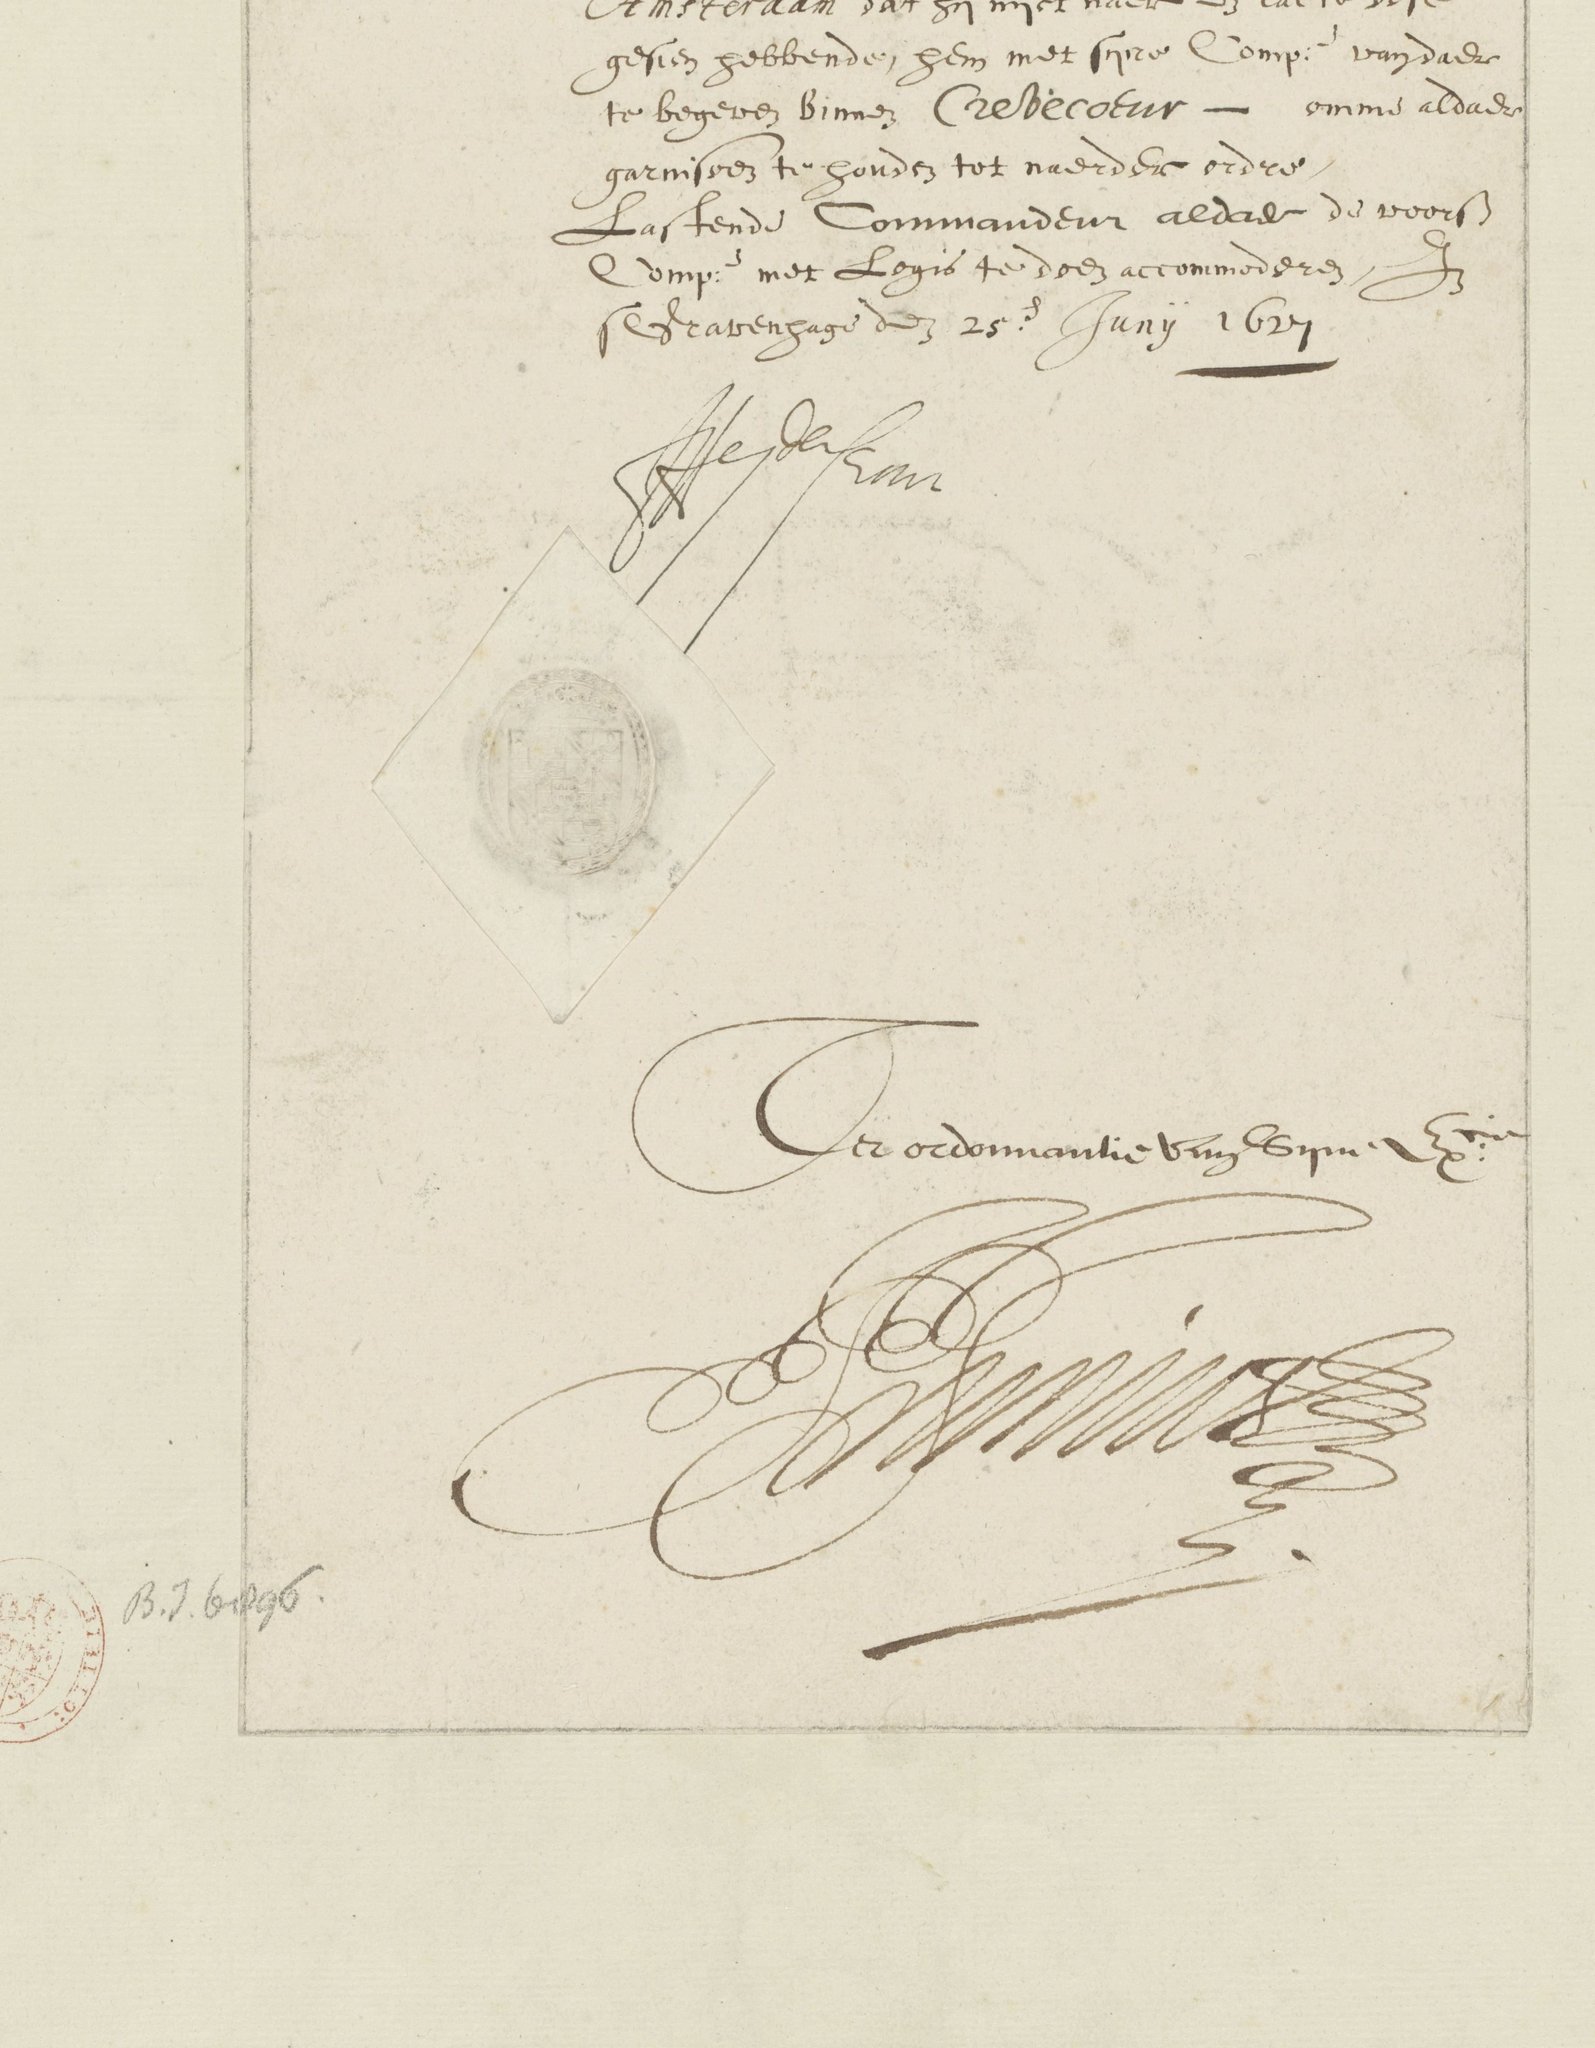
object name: document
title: Document bij het portret van Frederik Hendrik, prins van Oranje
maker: frederick henry (prince of orange)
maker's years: 1584-1647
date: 1627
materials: ink, paper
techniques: pen, writing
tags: delft, frederick henry (prince of orange)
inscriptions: inscription: ‘Onze […, de baas dus, wrsch Fredrik Hendrik] ordonneert hier mede den Cap.[itei]n Jacob Goossens sonder gelt van Amsterdam dat hij nyet naer en laete [niet nalaat] dese [ordonnantie] gesien hebbende hem met sijne Comp:[agnie] vandaer te begeven binnen Crevecoeur – omme aldaer garnisoen te houden tot naerder order Lastende Commandeur aldaer de voors[eid] Comp:[agnie] met Logis te doen accomoderen In s Gravenhage den 25. Junij 1627 [Handtekening van Frederik Hendrik] Ter ordonnantie van Sijn Exc[ellentie] [iemands anders handtekening]’, collector's mark: Lugt 240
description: Document bij het portret van Frederik Hendrik, gedateerd 25 juni 1627, waarin Jacob Goosens Sondergelt verordonneert wordt zich met zijn compagnie te begeven tot de schans Crèvecoeur. De brief draagt de handtekening van Frederik Hendrik en de zegel van de prins van Oranje.